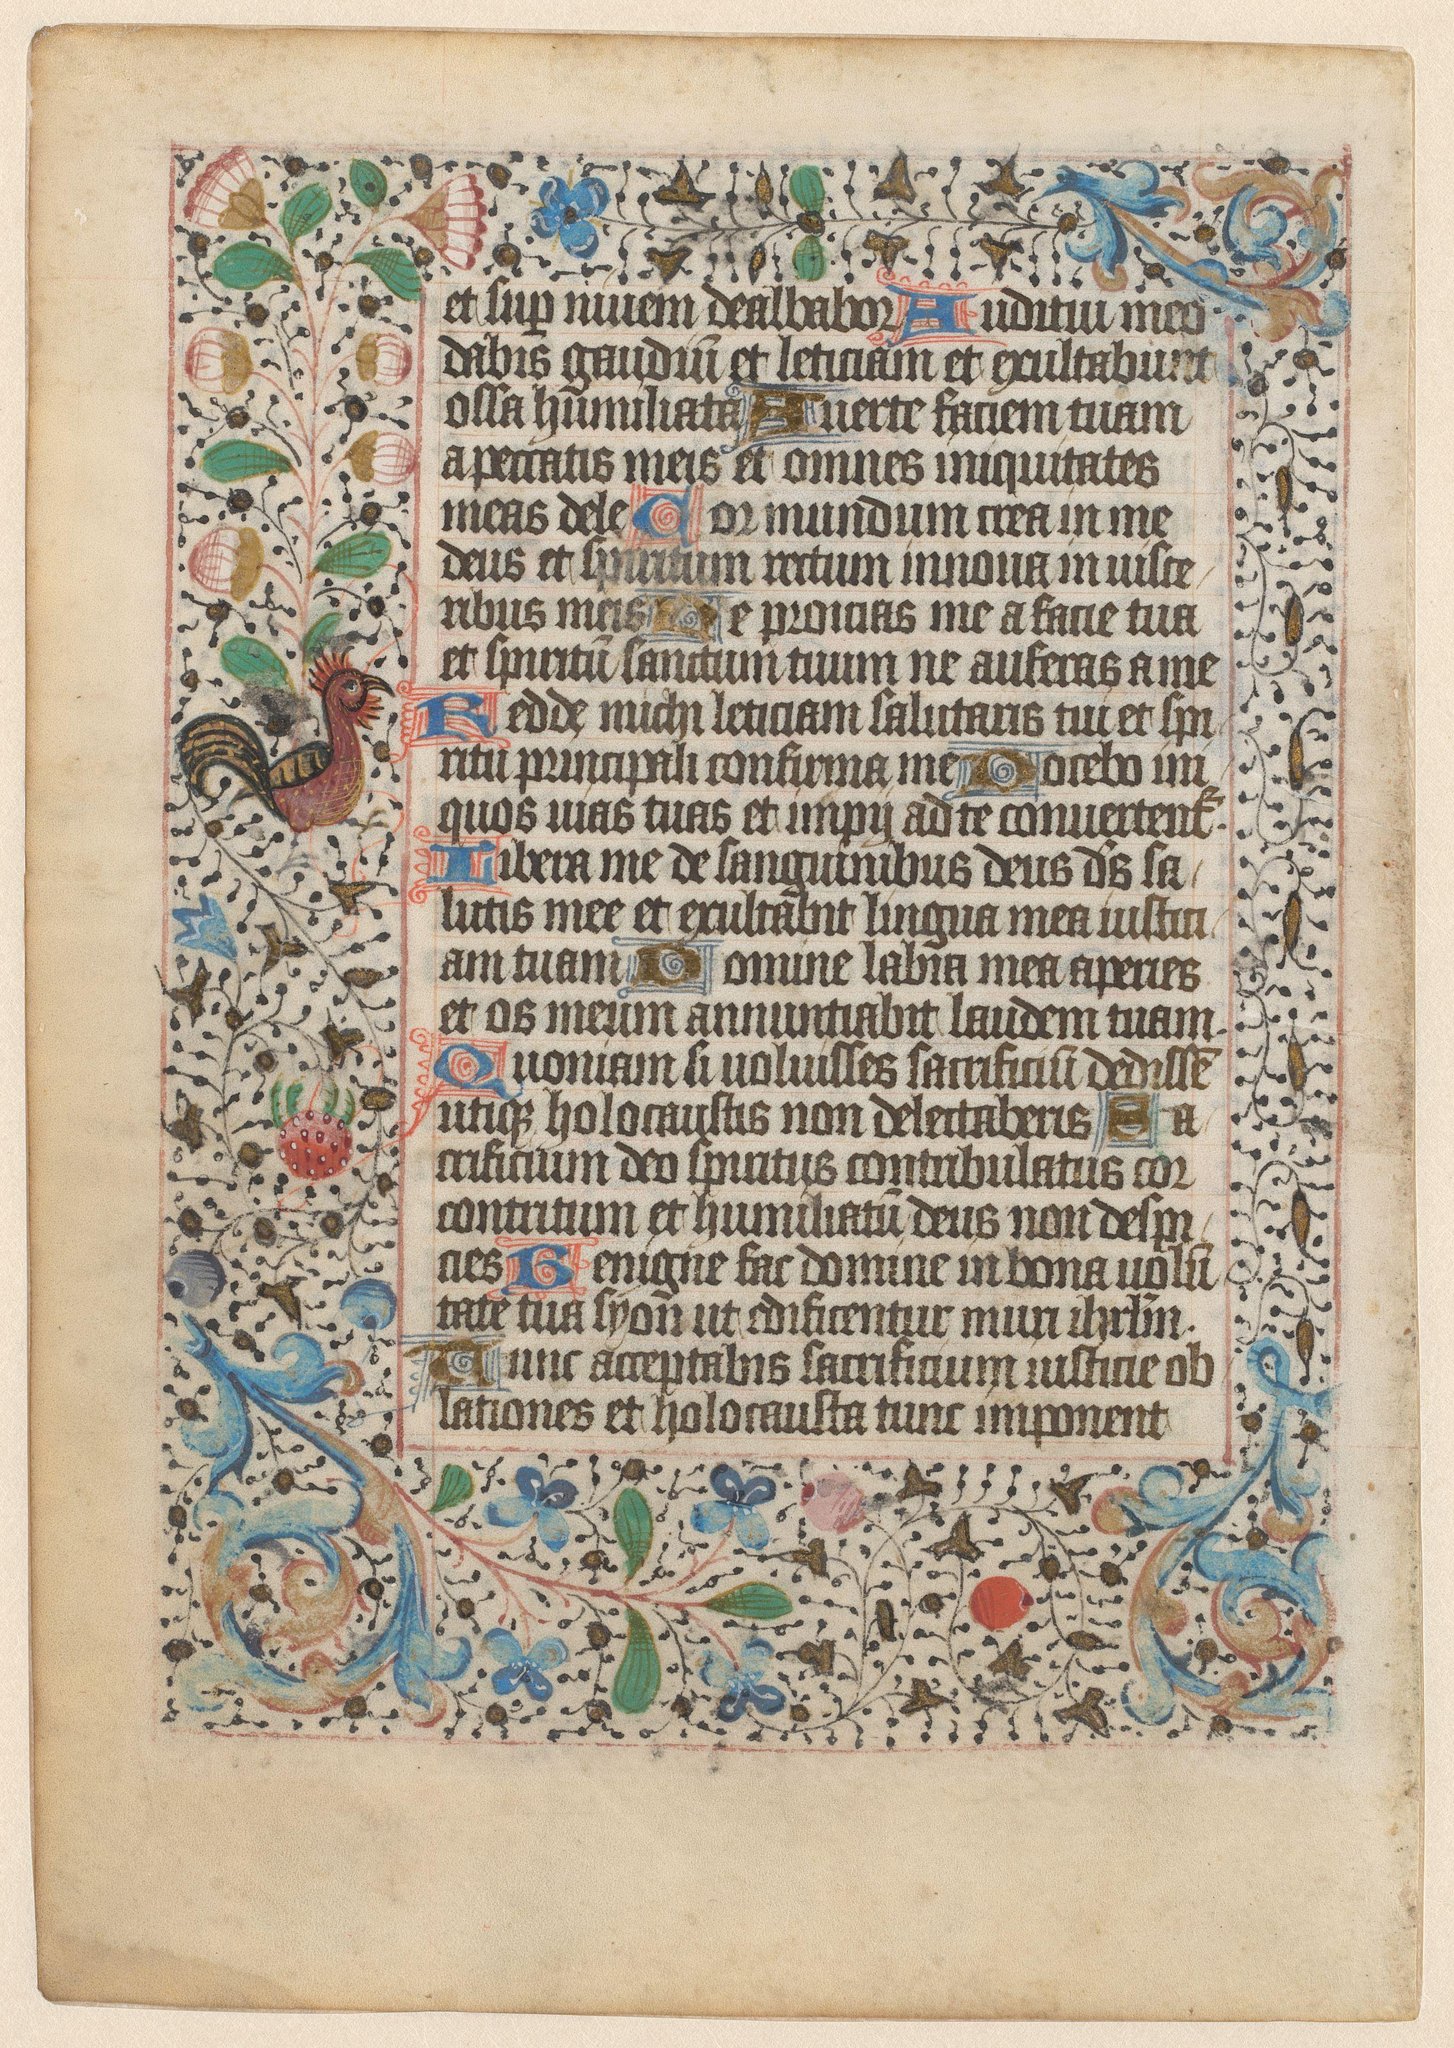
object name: drawing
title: Blad uit een verlucht handschrift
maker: Anonymous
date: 1300-1399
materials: paint, gold leaf, ink, parchment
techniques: brush, pen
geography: france